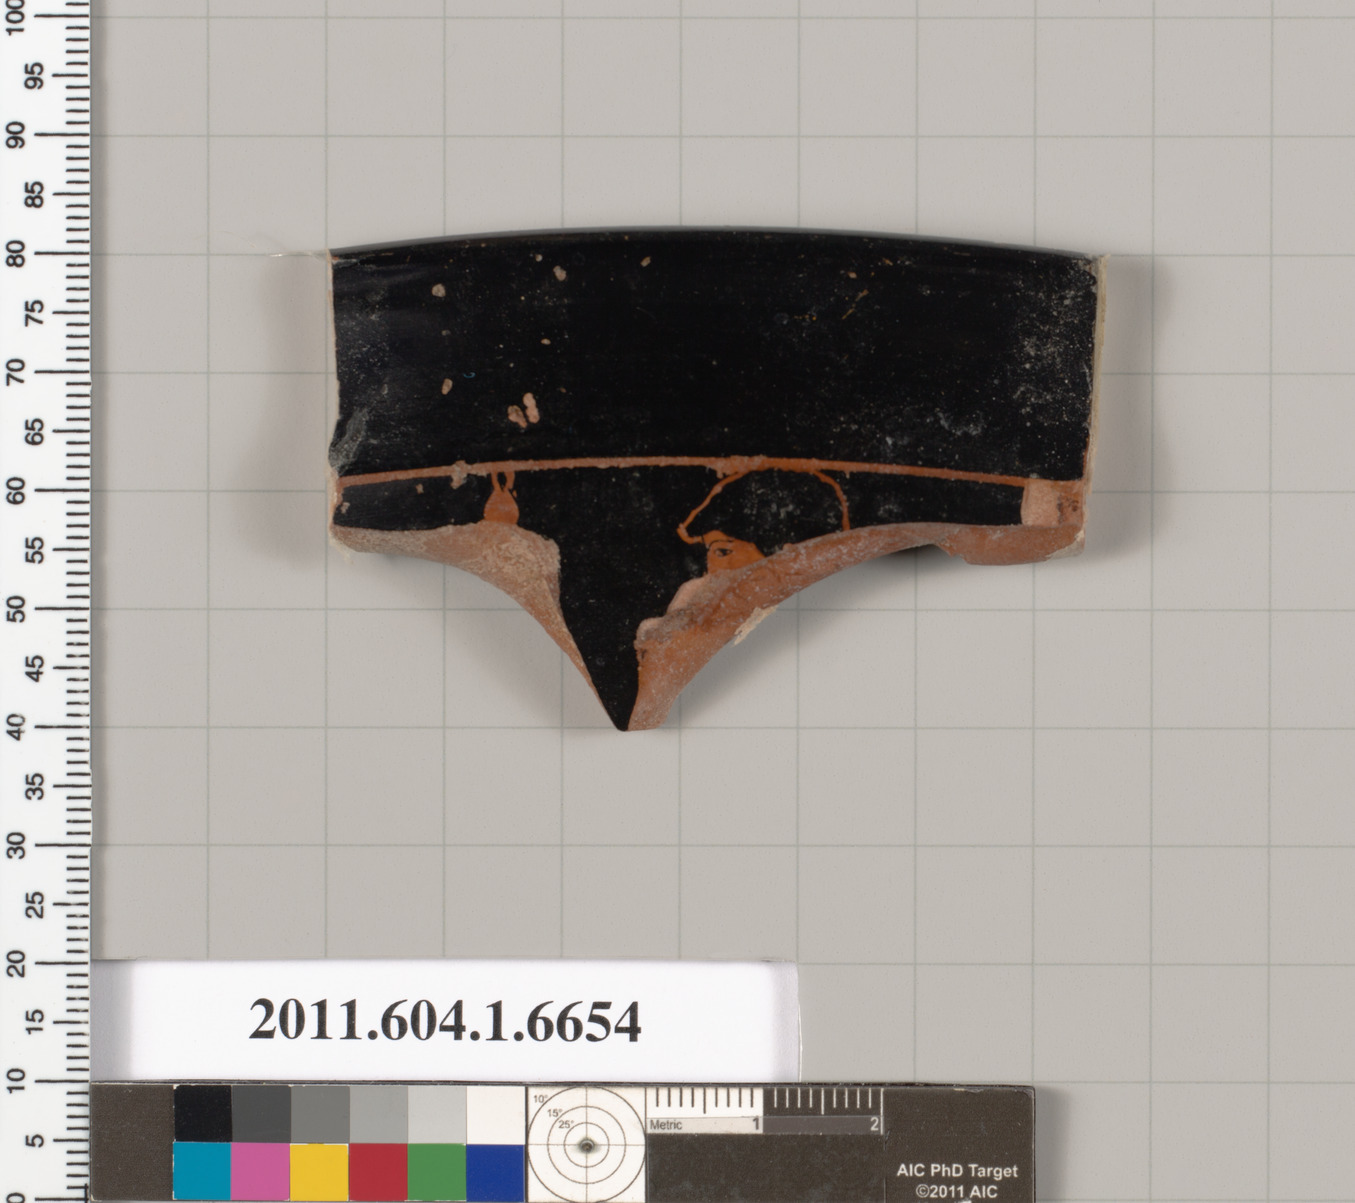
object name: kylix fragment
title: Terracotta rim fragment of a kylix (drinking cup)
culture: greek, attic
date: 490-470 BCE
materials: terracotta